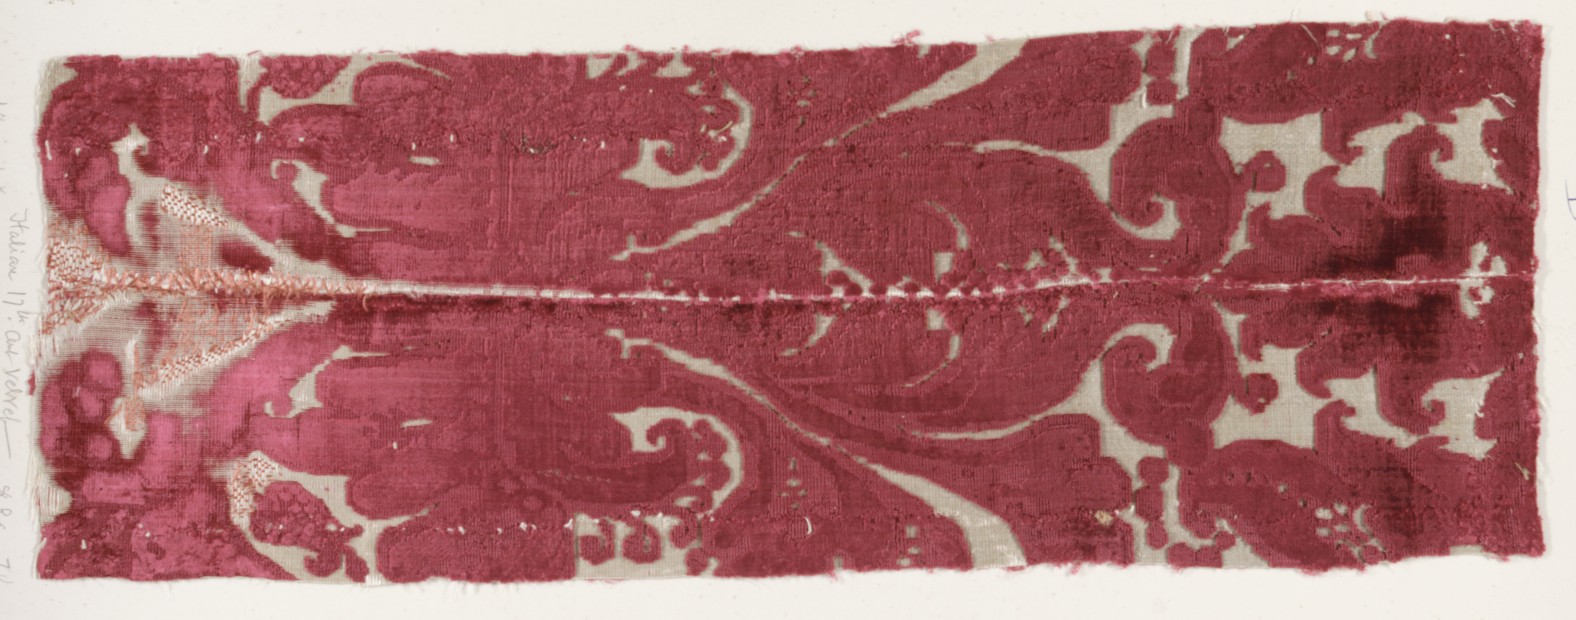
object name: fragment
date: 1601-1700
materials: silk